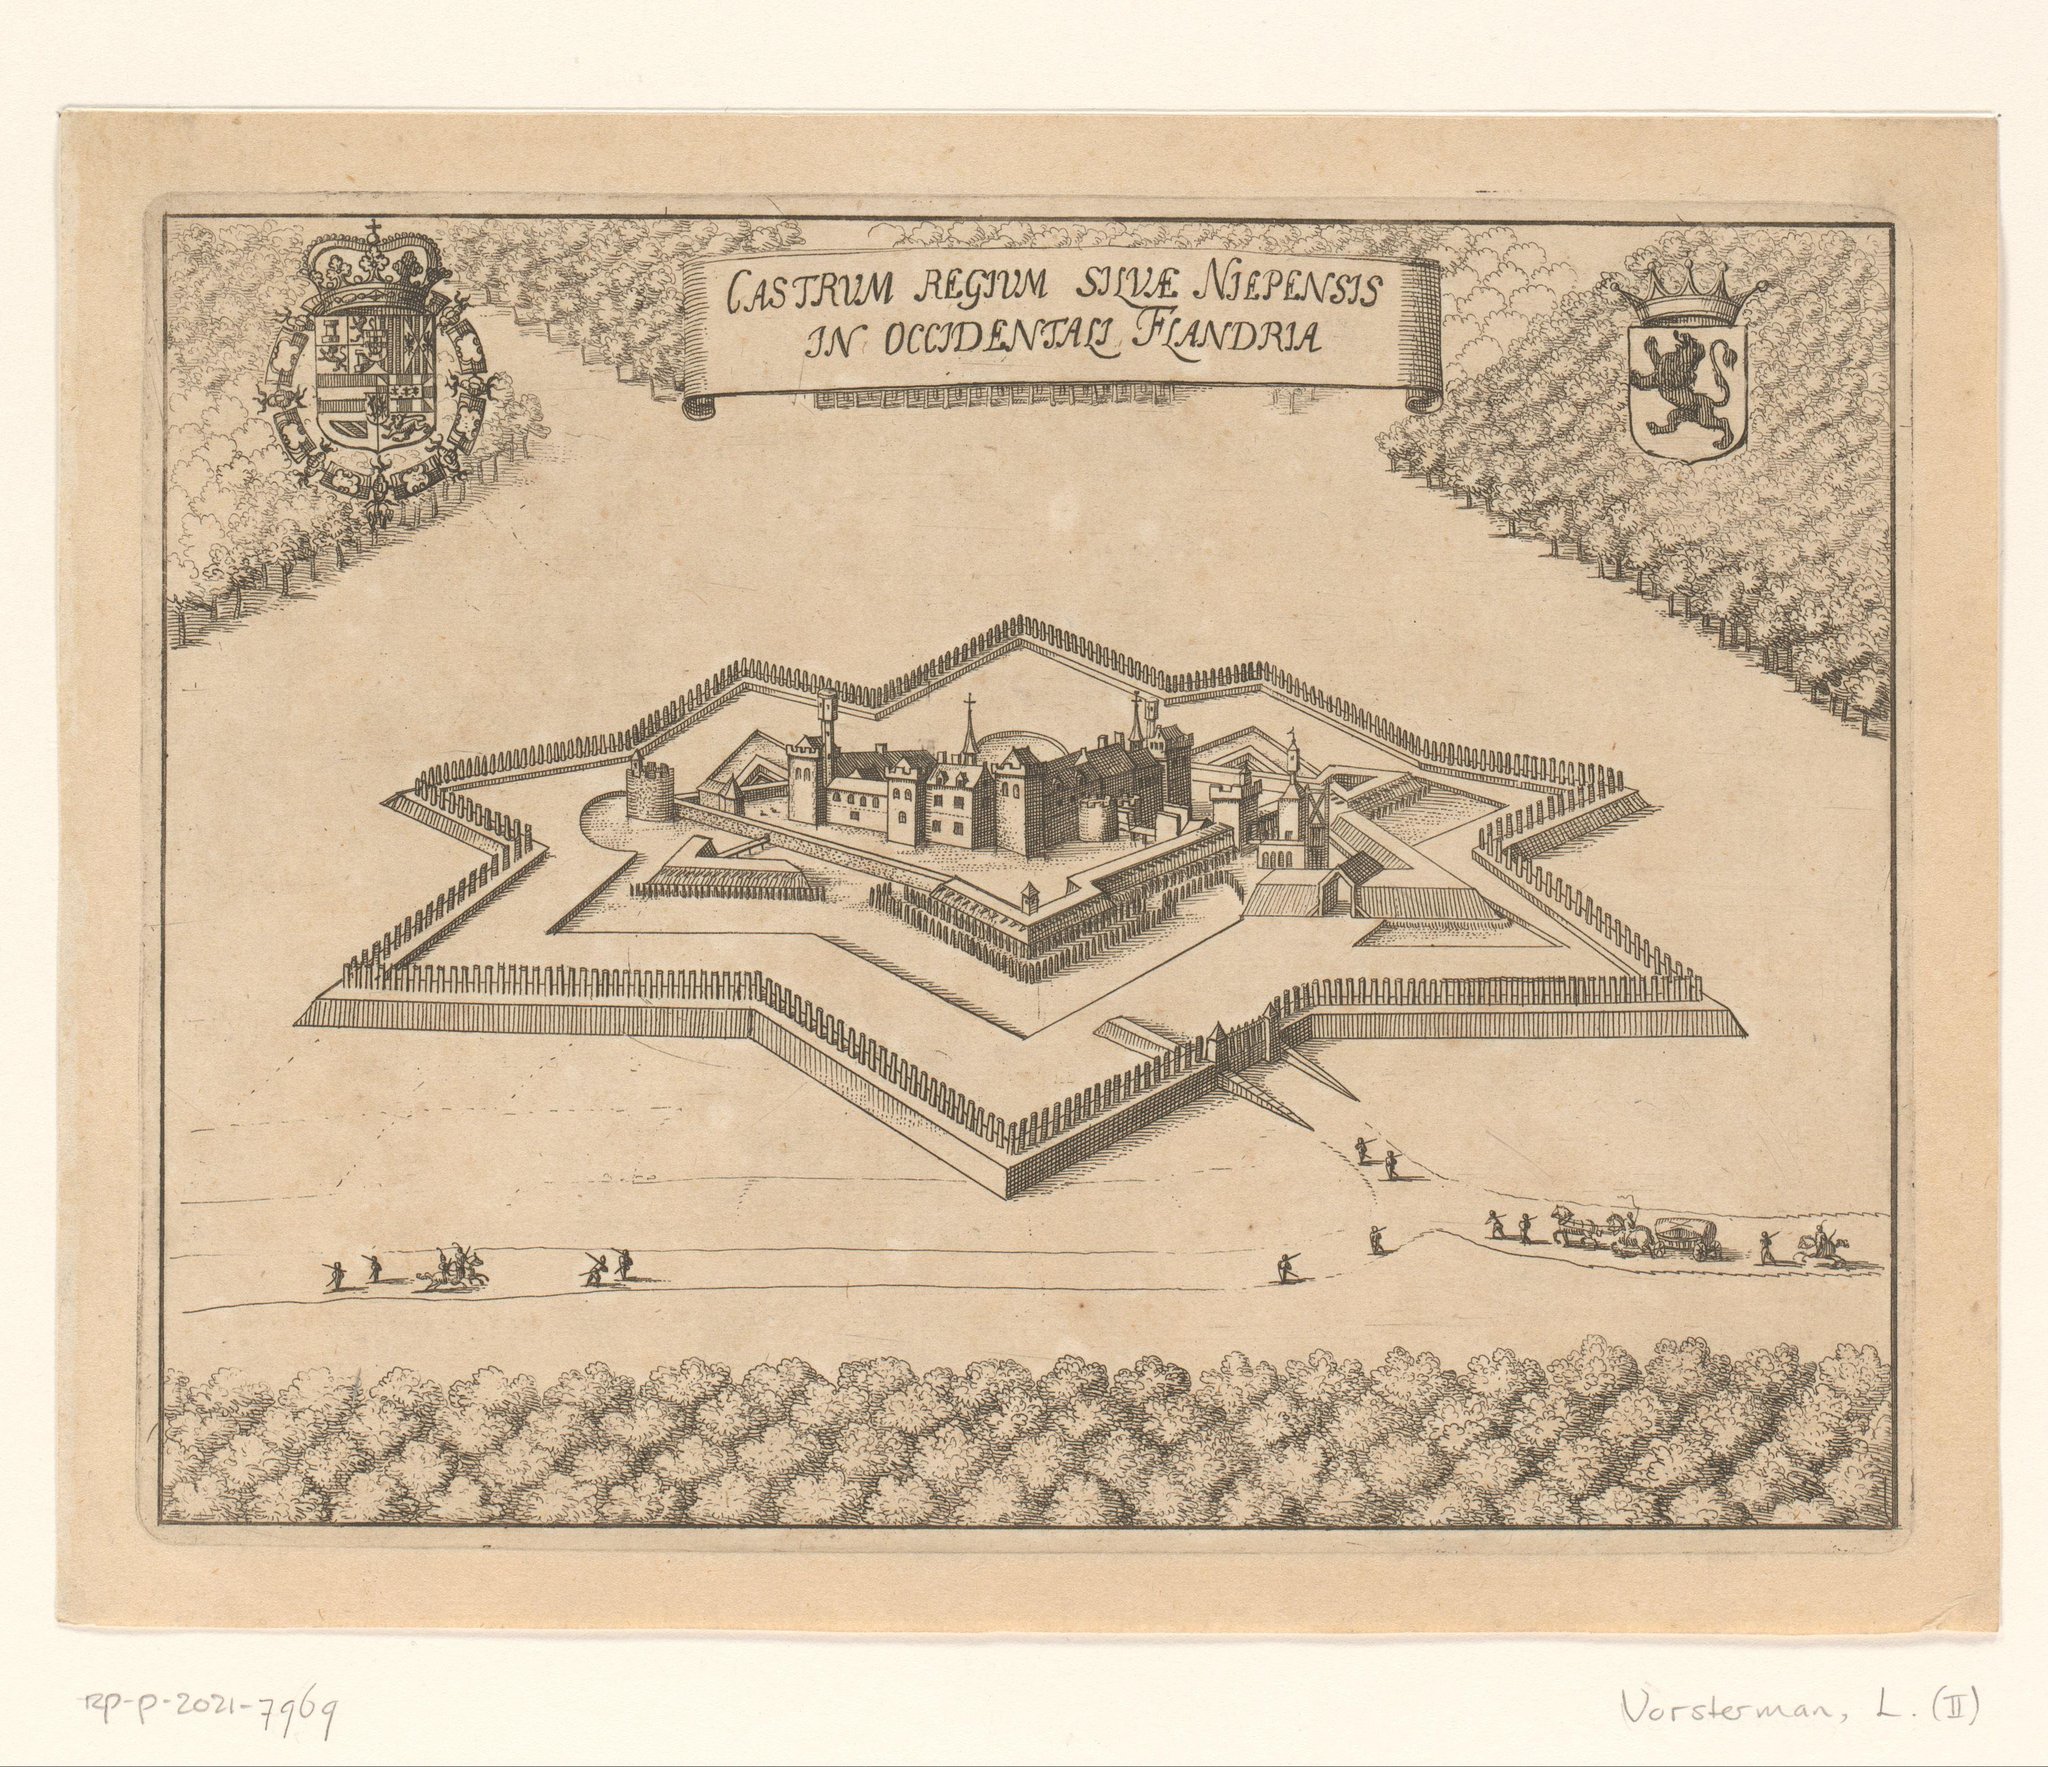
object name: print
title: Palatium Brugense Comitis Flandriae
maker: lucas vorsterman (ii)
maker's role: print maker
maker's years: 1624-1667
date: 1659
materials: paper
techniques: etching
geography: antwerp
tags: palace, inner court of palace or 'hôtel', armorial bearing, heraldry, bruges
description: Prent waarschijnlijk uit: Sanderus, Antonius. Chorographia sacra Brabantiae. Brussel: Philips Vleugaert, 1659.